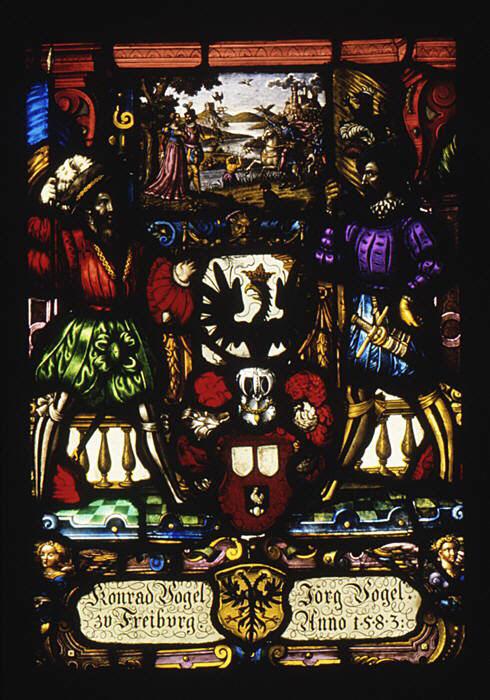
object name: armorial panel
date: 1583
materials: glass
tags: men,women,landscapes